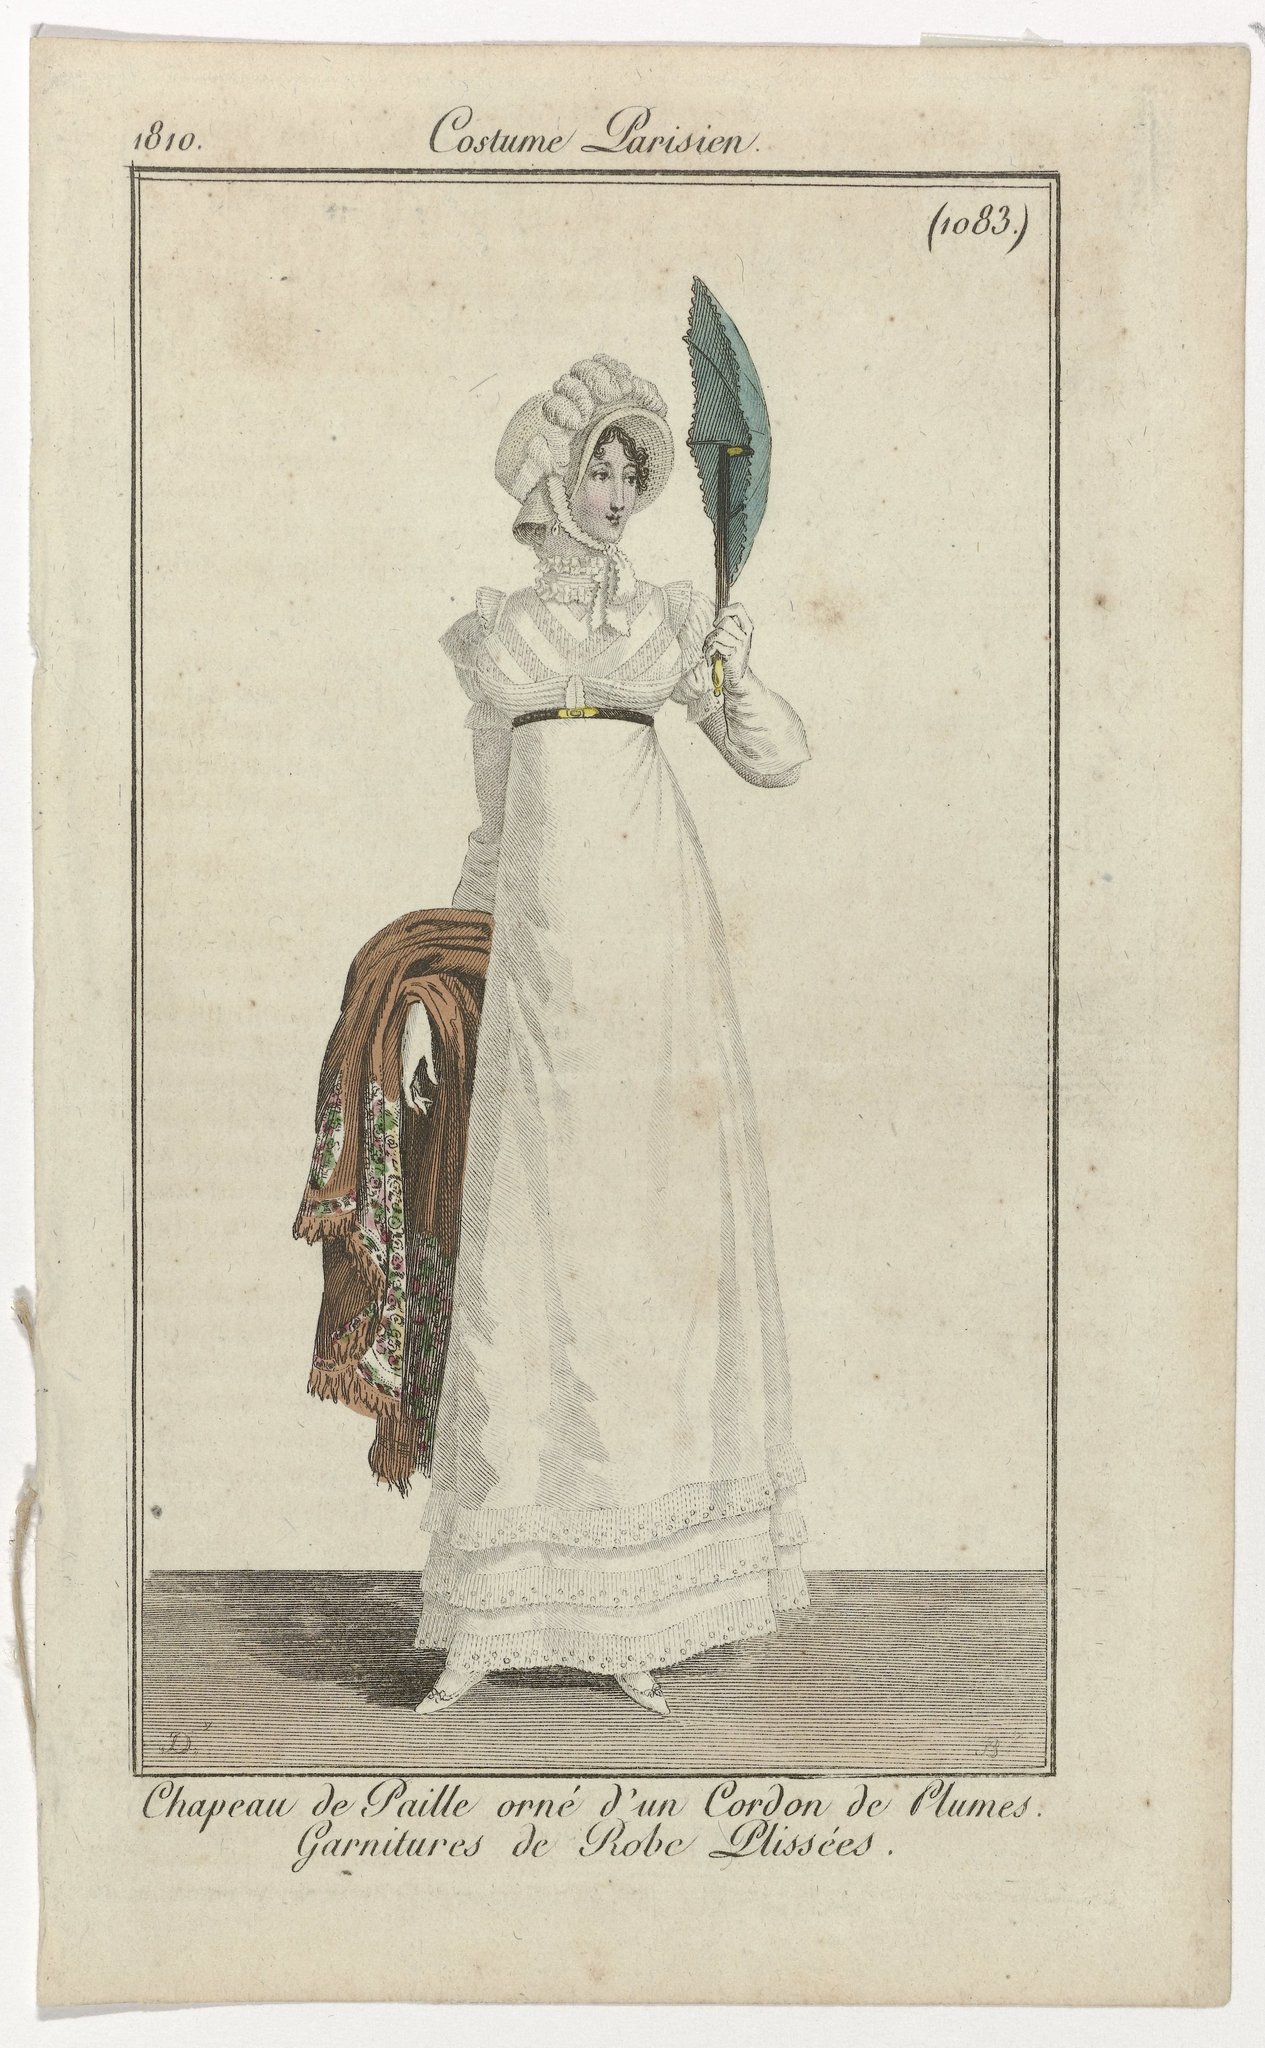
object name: fashion print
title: Journal des Dames et des Modes, Costume Parisien, 25 août 1810, (1083): Chapeau de paill (...)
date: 1810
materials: paper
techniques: engraving, hand coloring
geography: paris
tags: ear-rings (+ women's clothes), gloves, mittens (long gloves) (+ women's clothes), clothing for the upper part of the body (shawl) (+ women's clothes), ornamental parts of clothing (+ women's clothes), head-gear (straw hat) (+ women's clothes), fashion plates, shoes, sandals (+ women's clothes), dress, gown (+ women's clothes), parasol, sunshade (+ women's clothes), belt, girdle, waistband (+ women's clothes)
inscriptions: caption: ‘Chapeau de Paille orné d'un Cordon de Plumes. Garnitures de Robe Plissées.’, title: ‘Costume Parisien.’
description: Staande vrouw met op het hoofd een strohoed, versierd met een rij van veren. Zij draagt een japon met korte pofmouwen, gegarneerd met geplooide stroken stof. Verdere accessoires: oorbel in het rechteroor, parasol met gekanteld dek, ceintuur, lange handschoenen, sjaal afgezet met franjes, platte schoenen met strikken. De prent maakt deel uit van het modetijdschrift Journal des Dames et des Modes, uitgegeven door Pierre de la Mésangère, Parijs, 1797-1839.